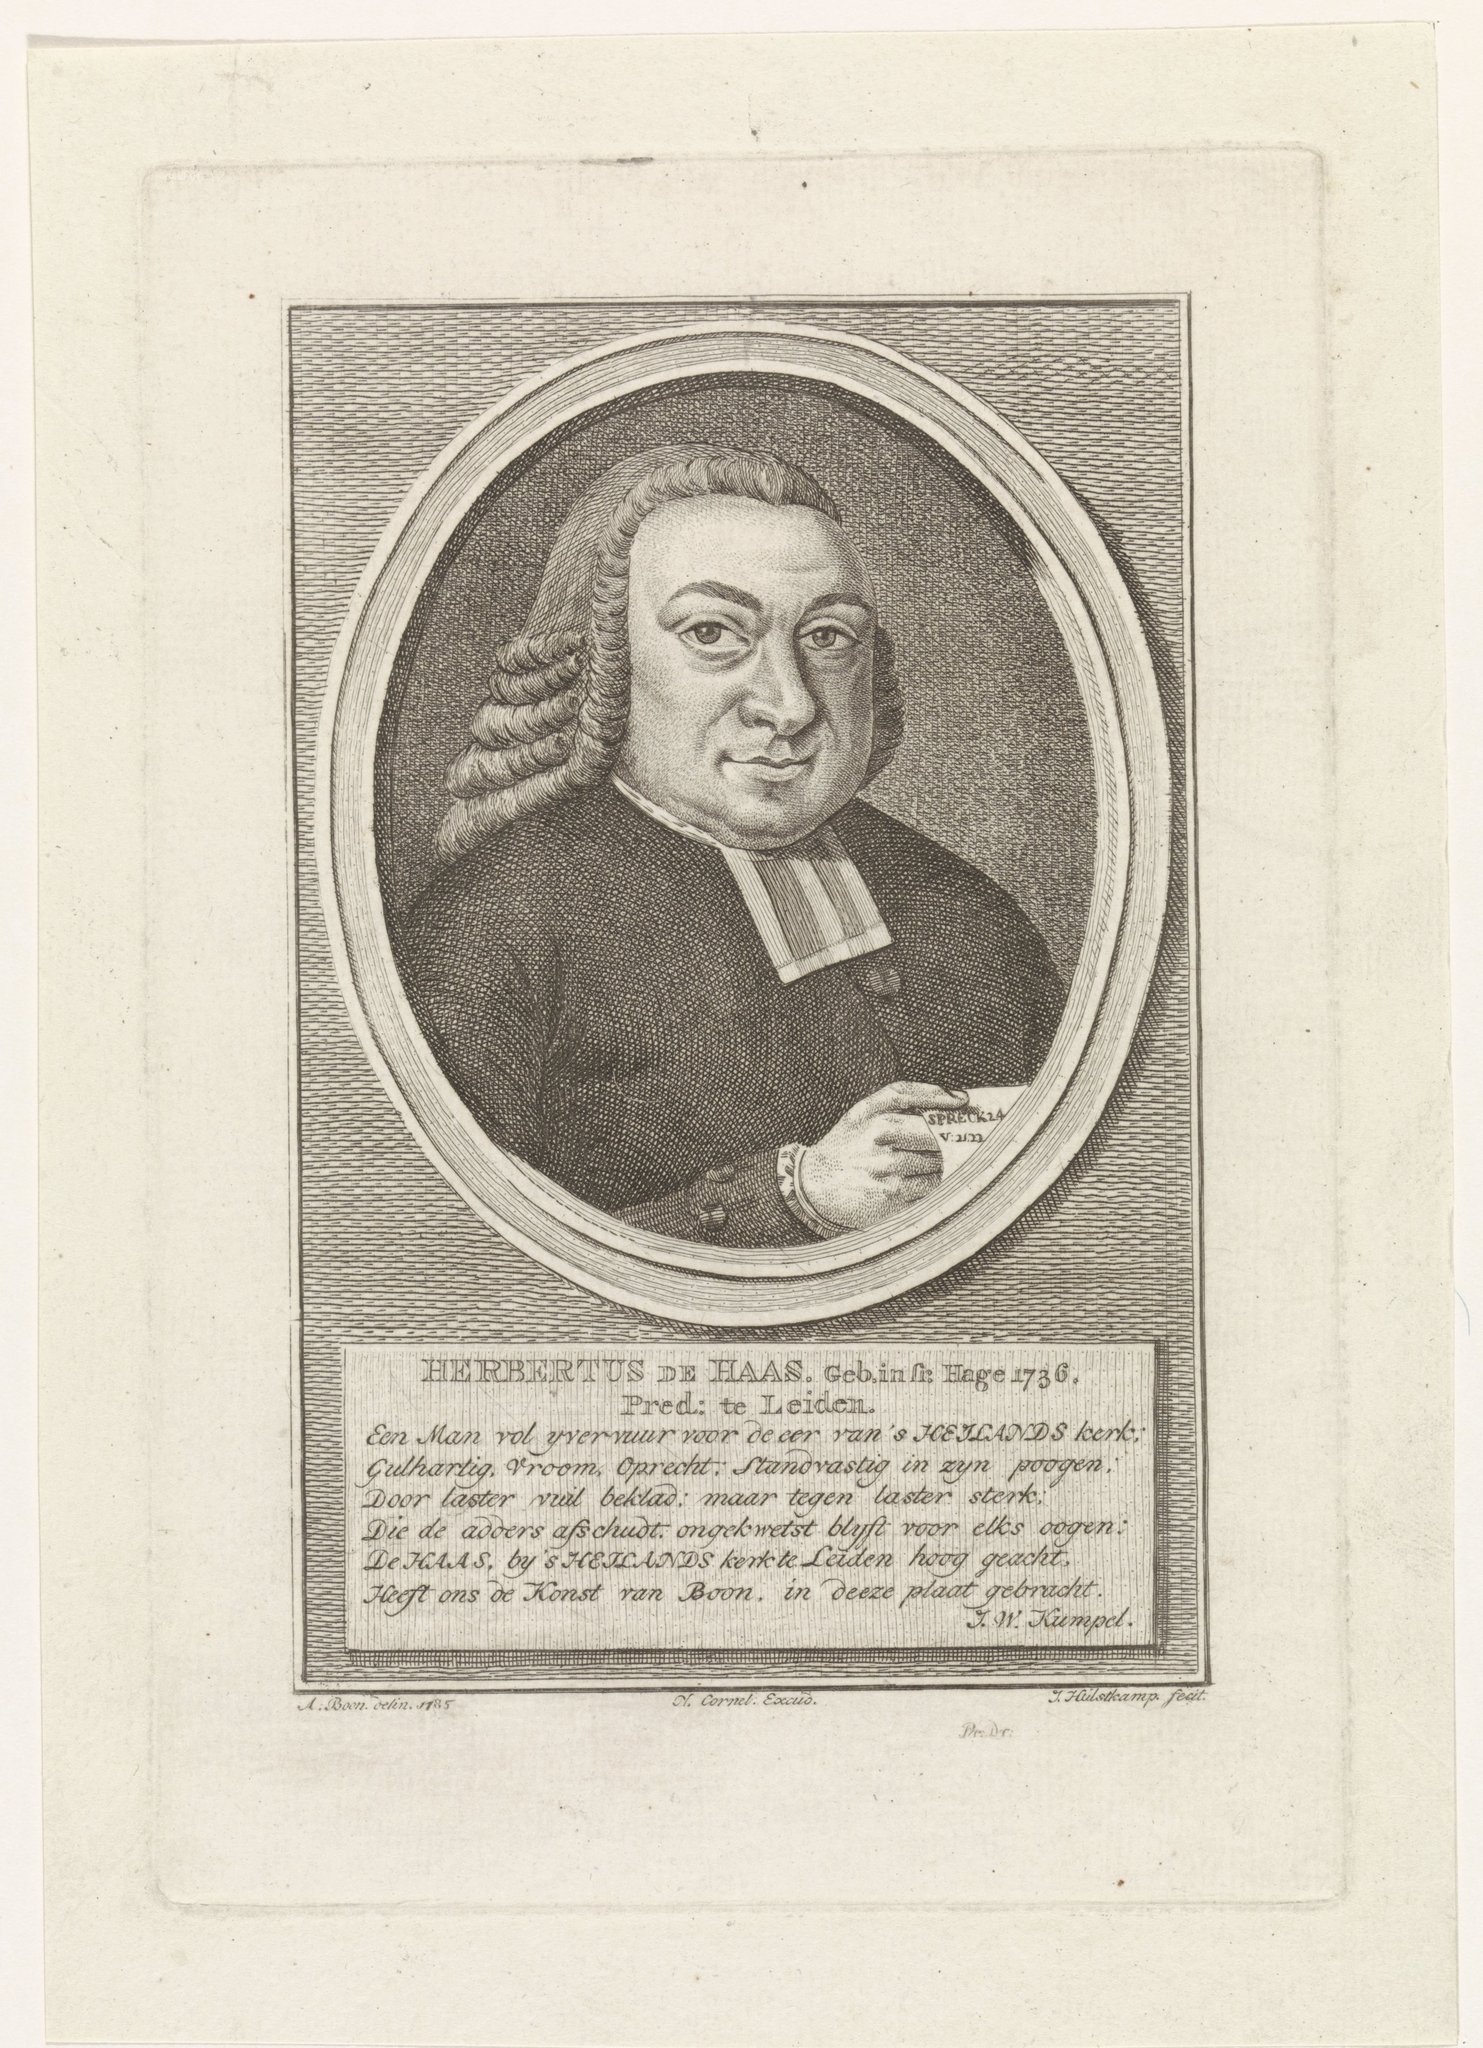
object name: print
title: Portret van Herbertus de Haas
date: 1785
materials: paper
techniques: engraving, etching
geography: rotterdam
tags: predikant, herbertus de haas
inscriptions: collector's mark: Lugt 2228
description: Herbertus de Haas met in zijn linkerhand een blad met de tekst: Spreuk 24 v: 21-22. Buste naar rechts in ovaal.